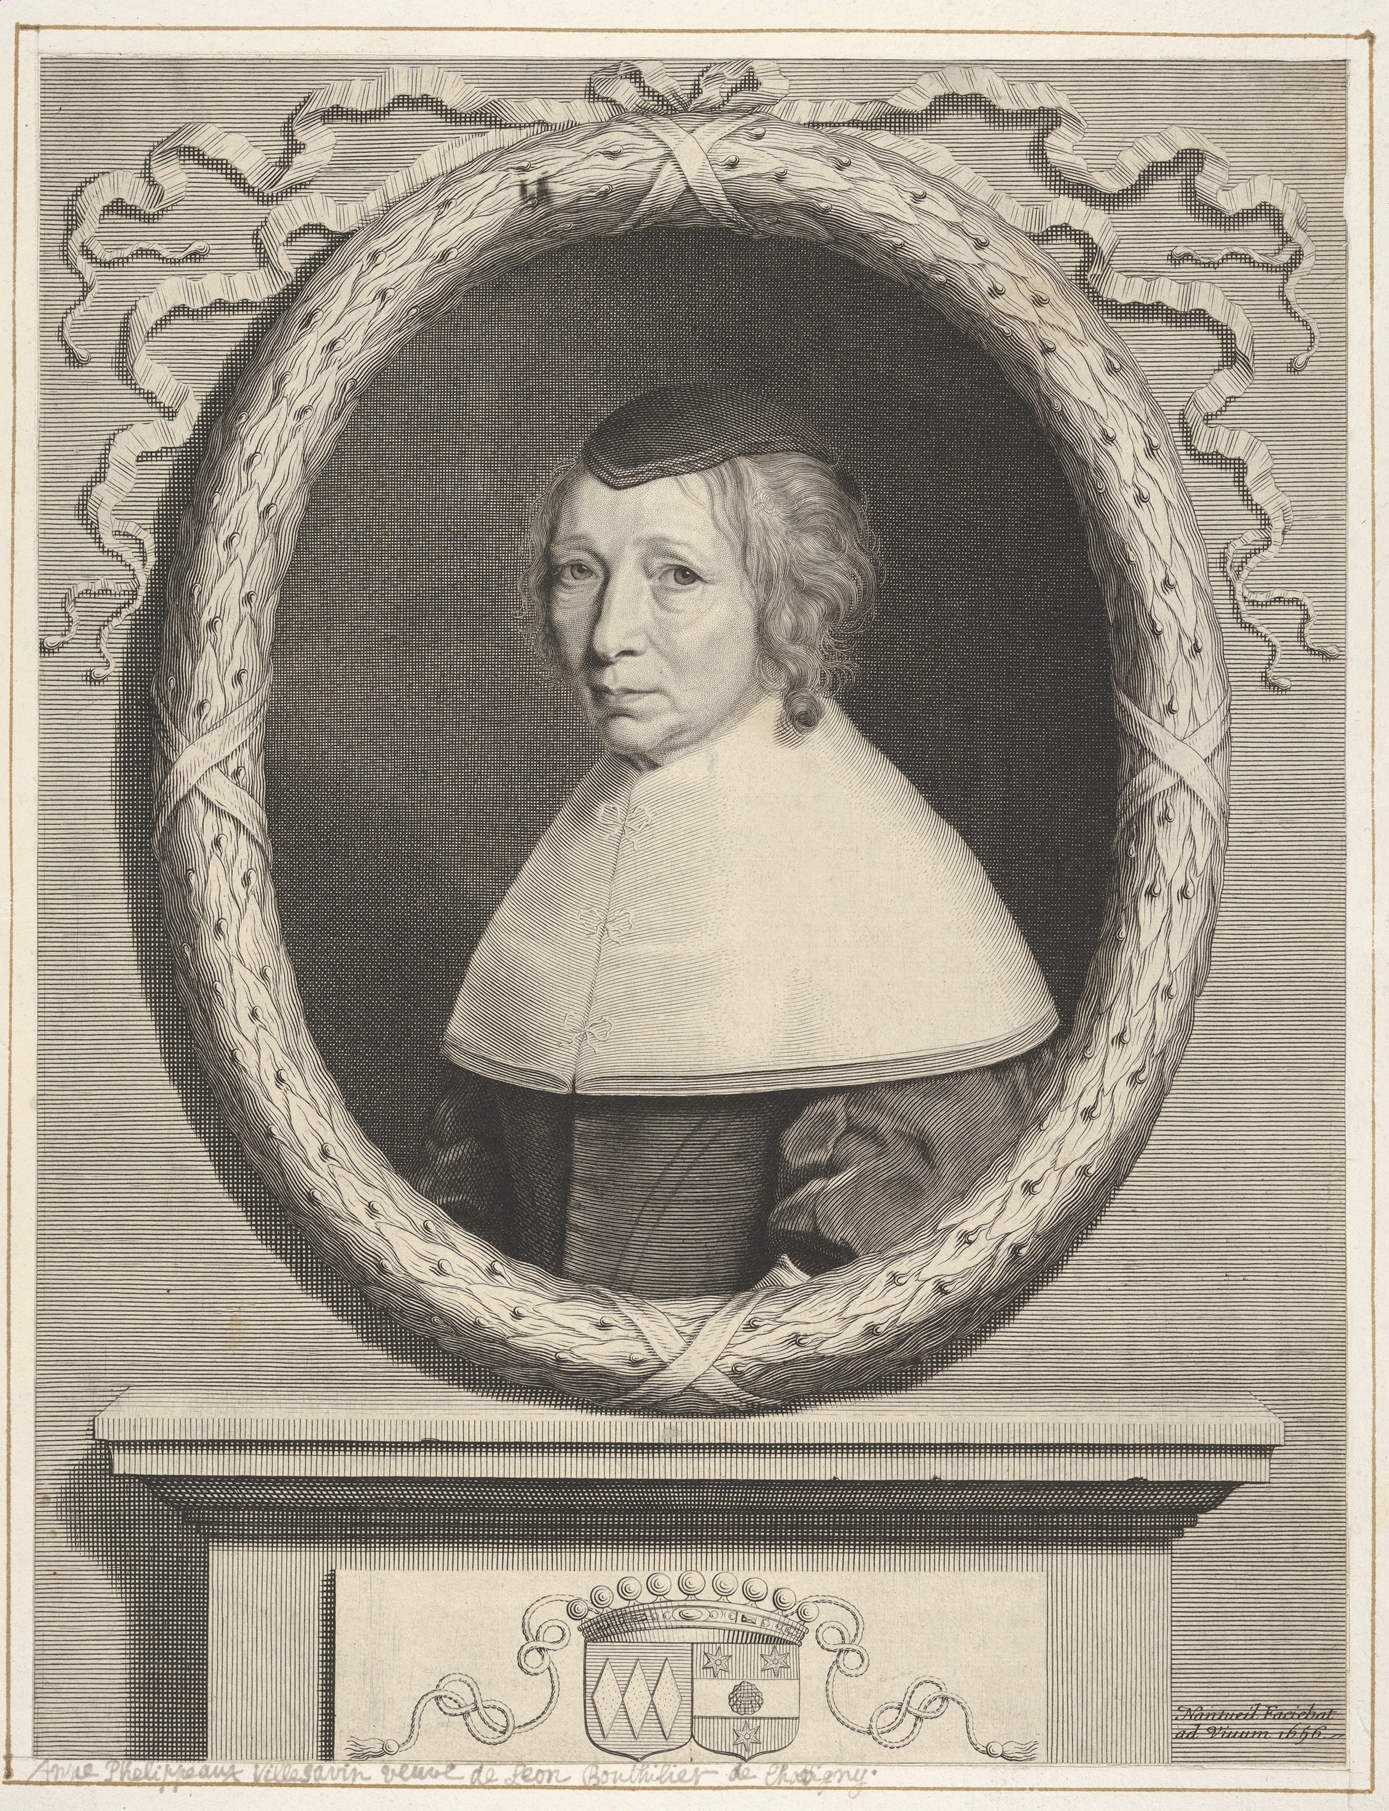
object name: print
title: Madame Bouthillier (Marie de Bragelogne)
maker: robert nanteuil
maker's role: artist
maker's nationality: french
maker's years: 1623-1678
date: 1656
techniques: engraving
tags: portraits,women,coat of arms